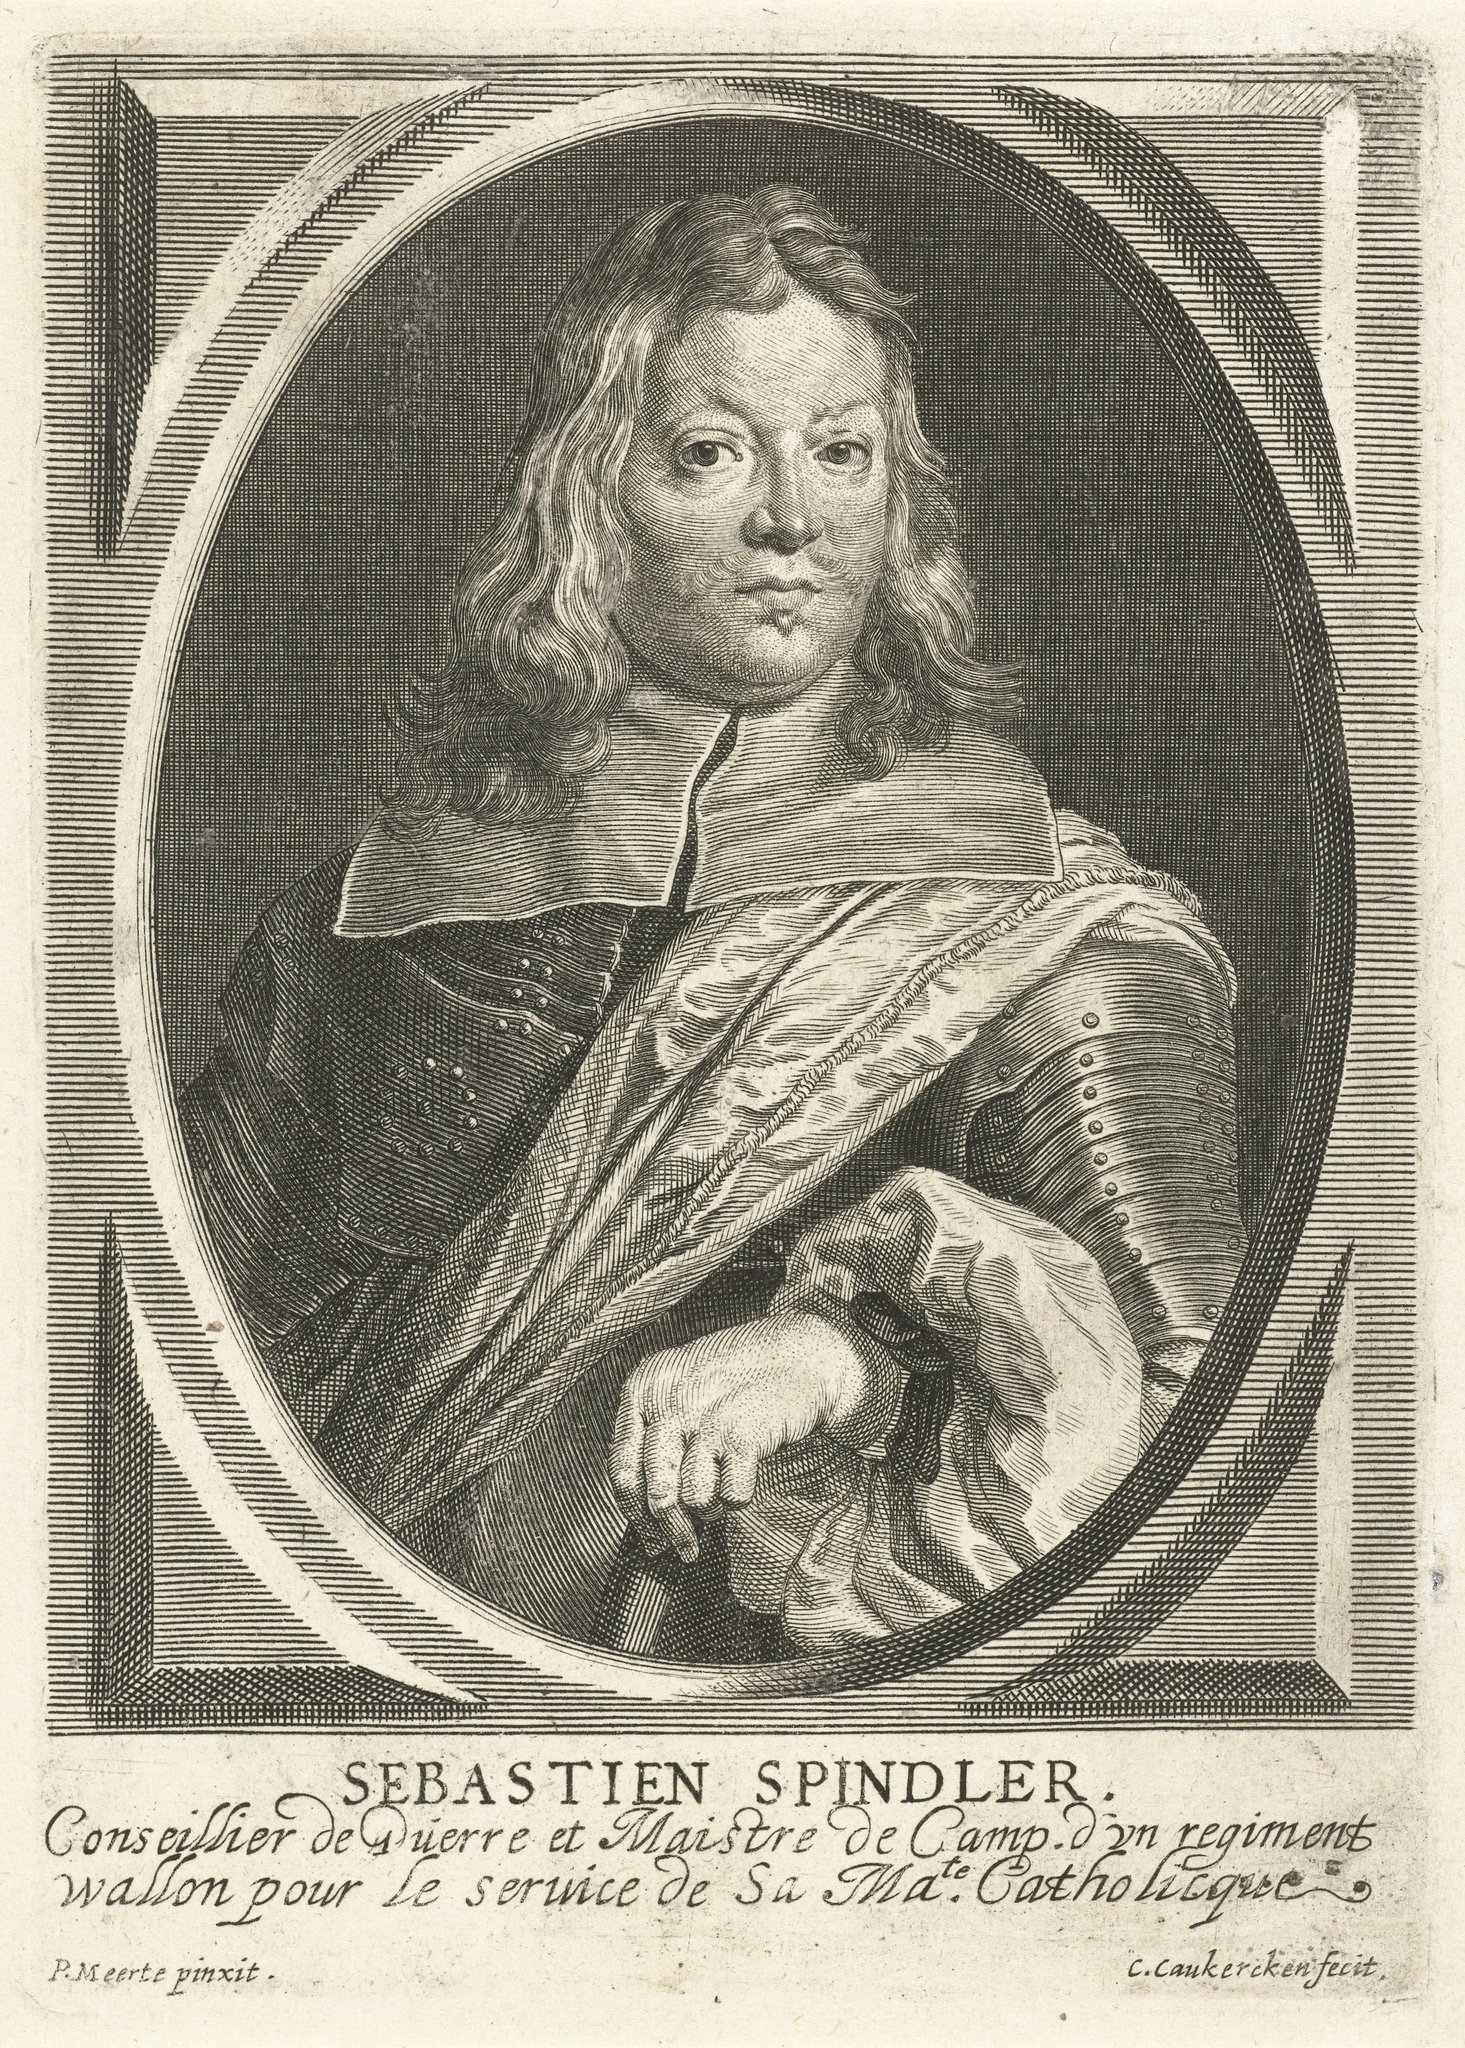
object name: print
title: Portret van Sebastien Spindeleer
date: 1640-1680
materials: paper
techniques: engraving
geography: southern netherlands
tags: sébastien spindeleer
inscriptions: collector's mark: Lugt 2228